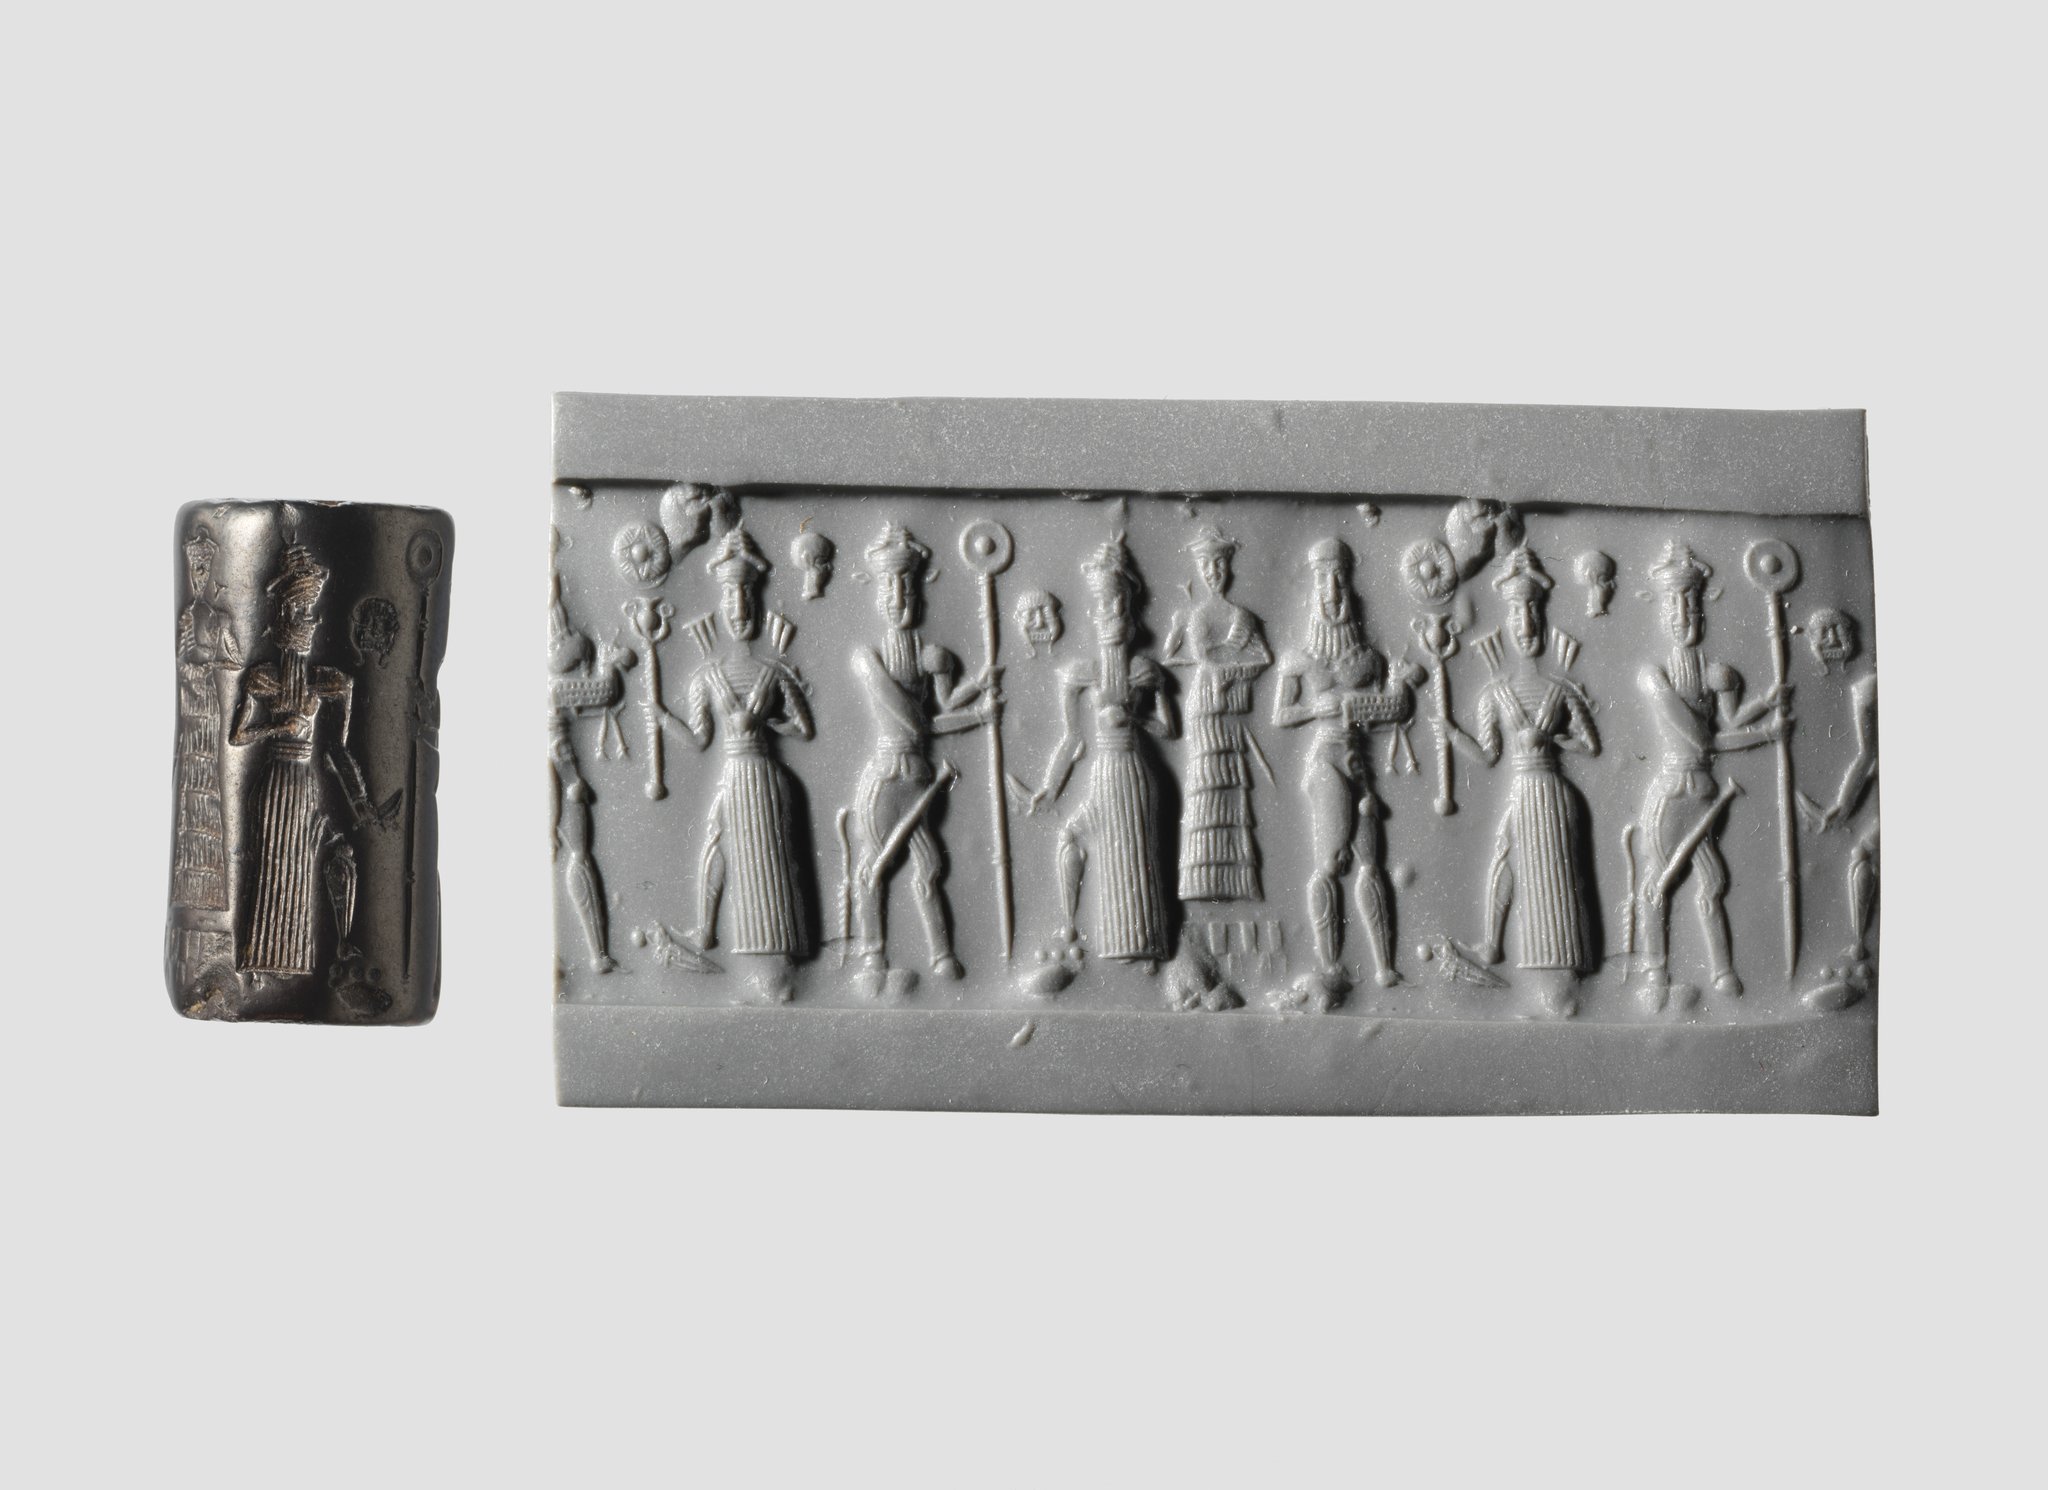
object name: cylinder seal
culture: babylonian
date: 2000-1668 BCE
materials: mineral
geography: mesopotamia